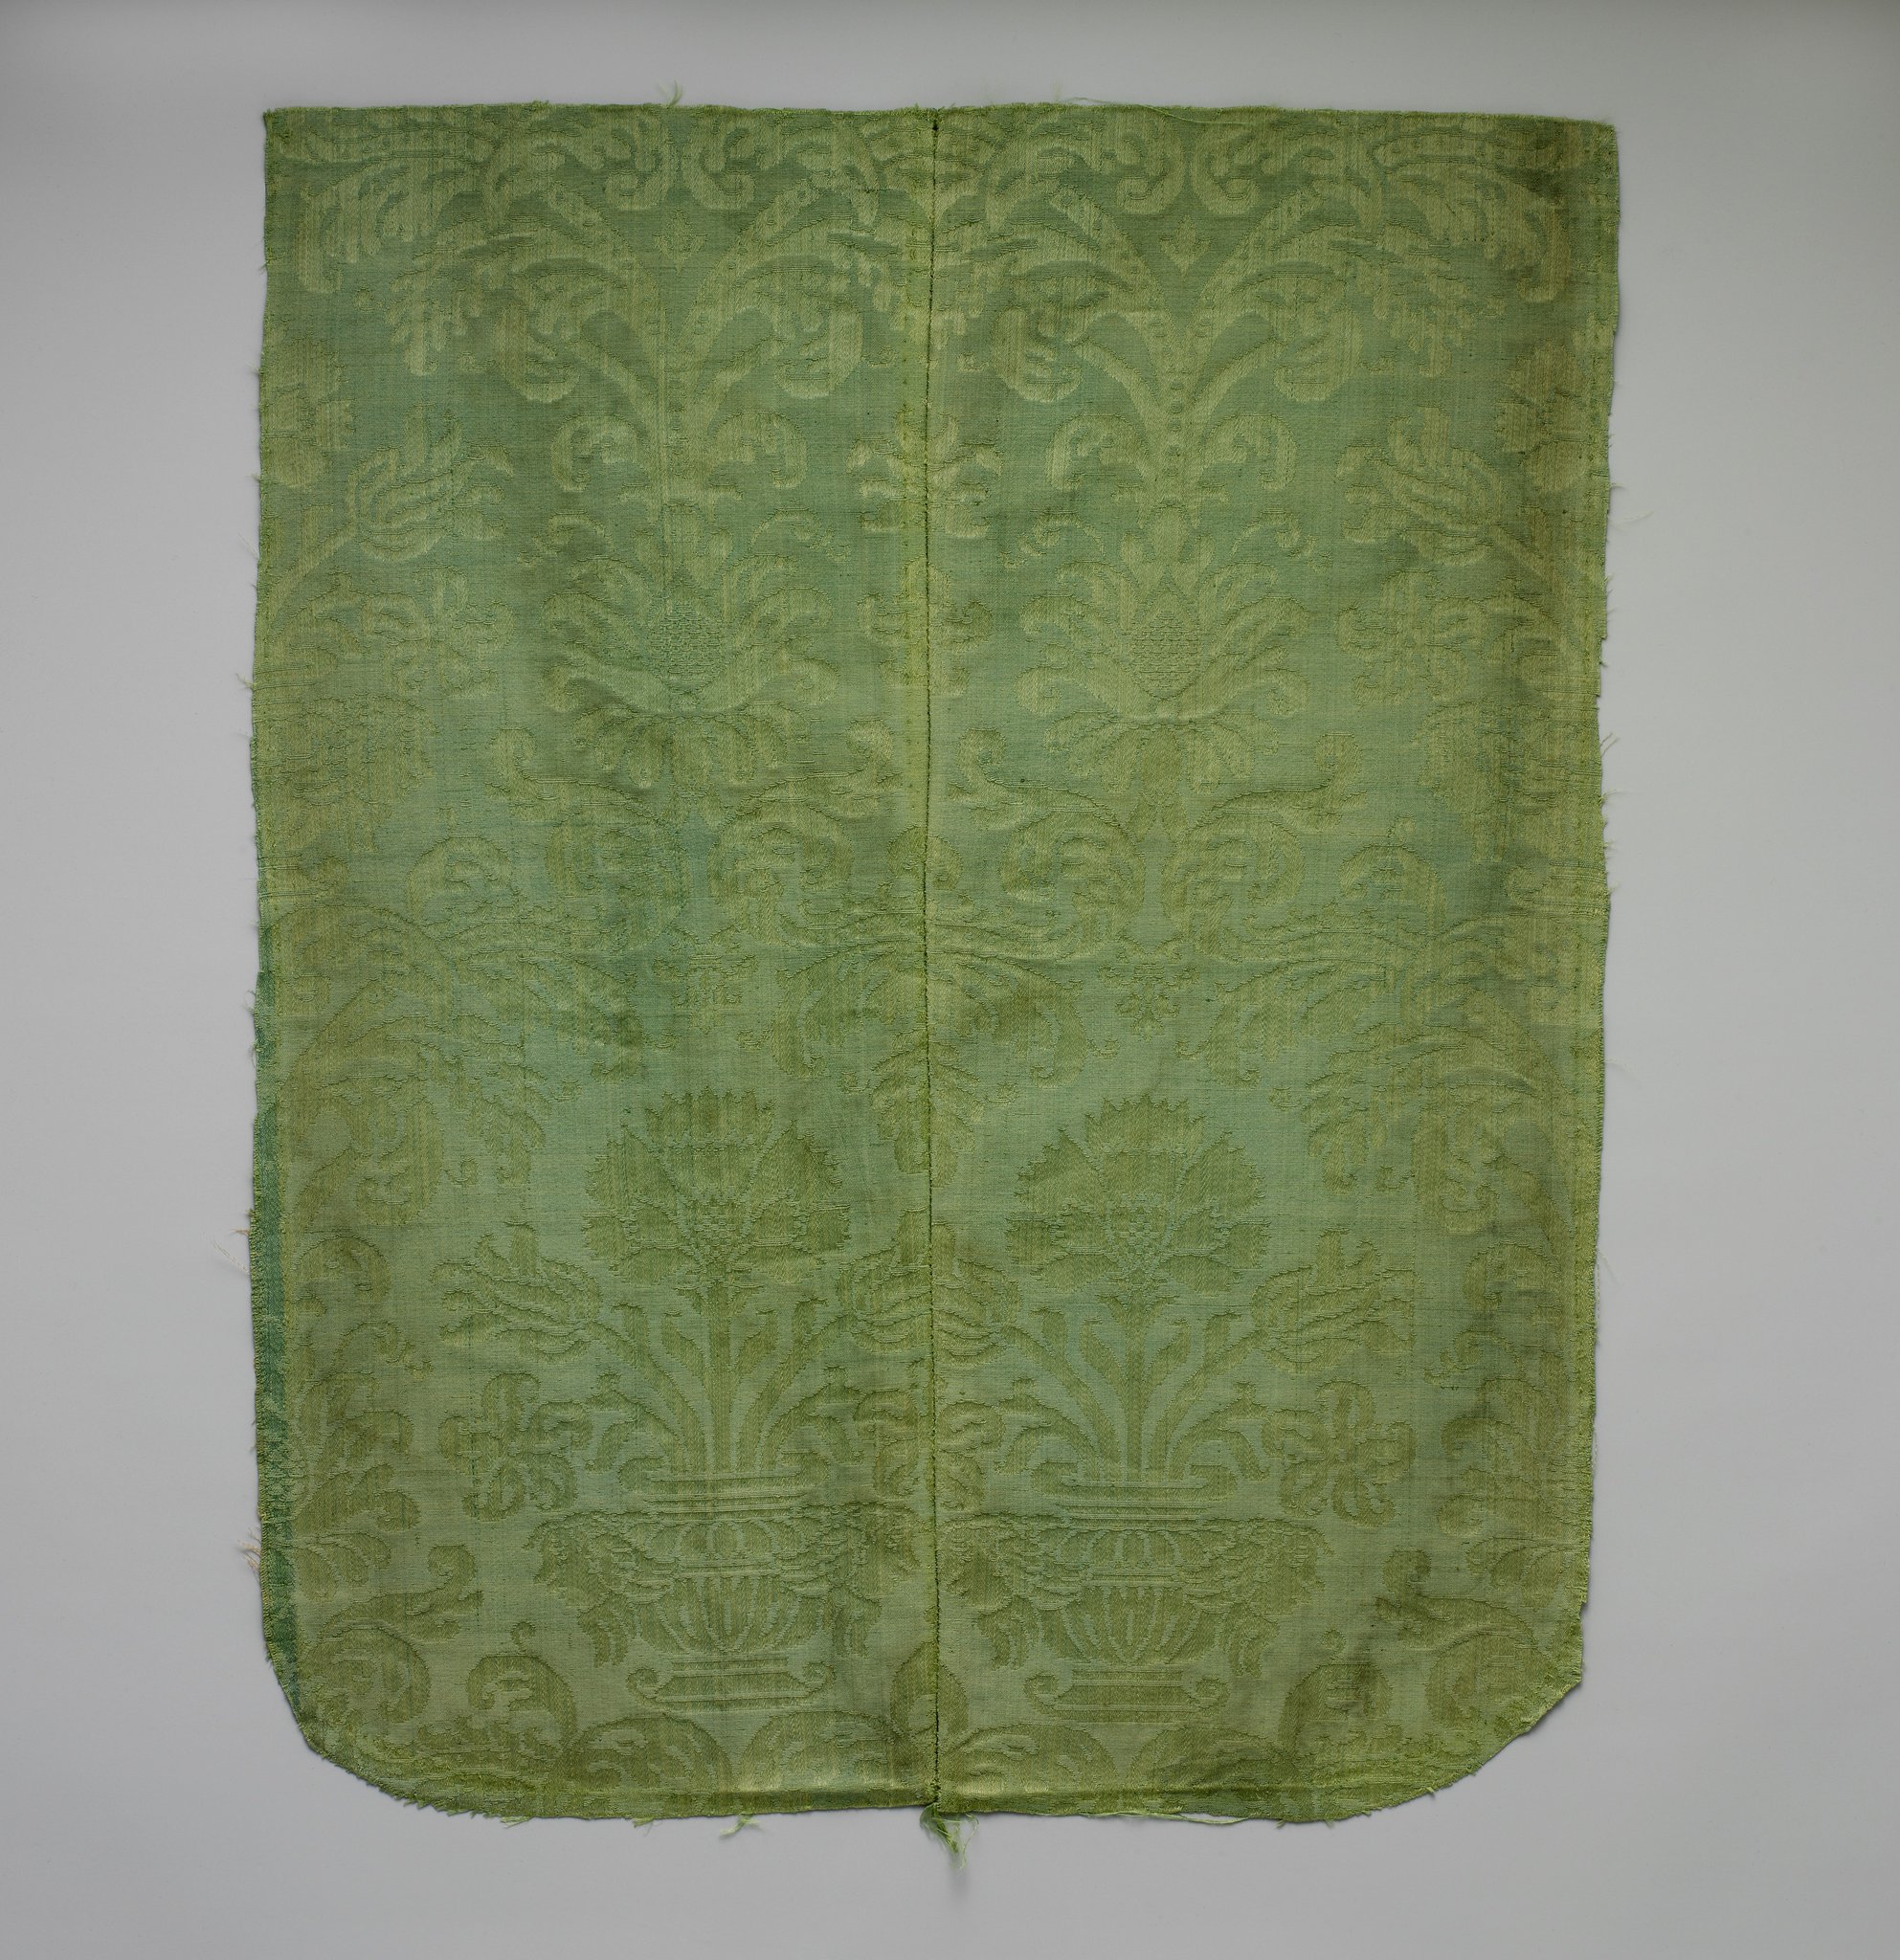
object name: piece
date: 1567-1633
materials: silk